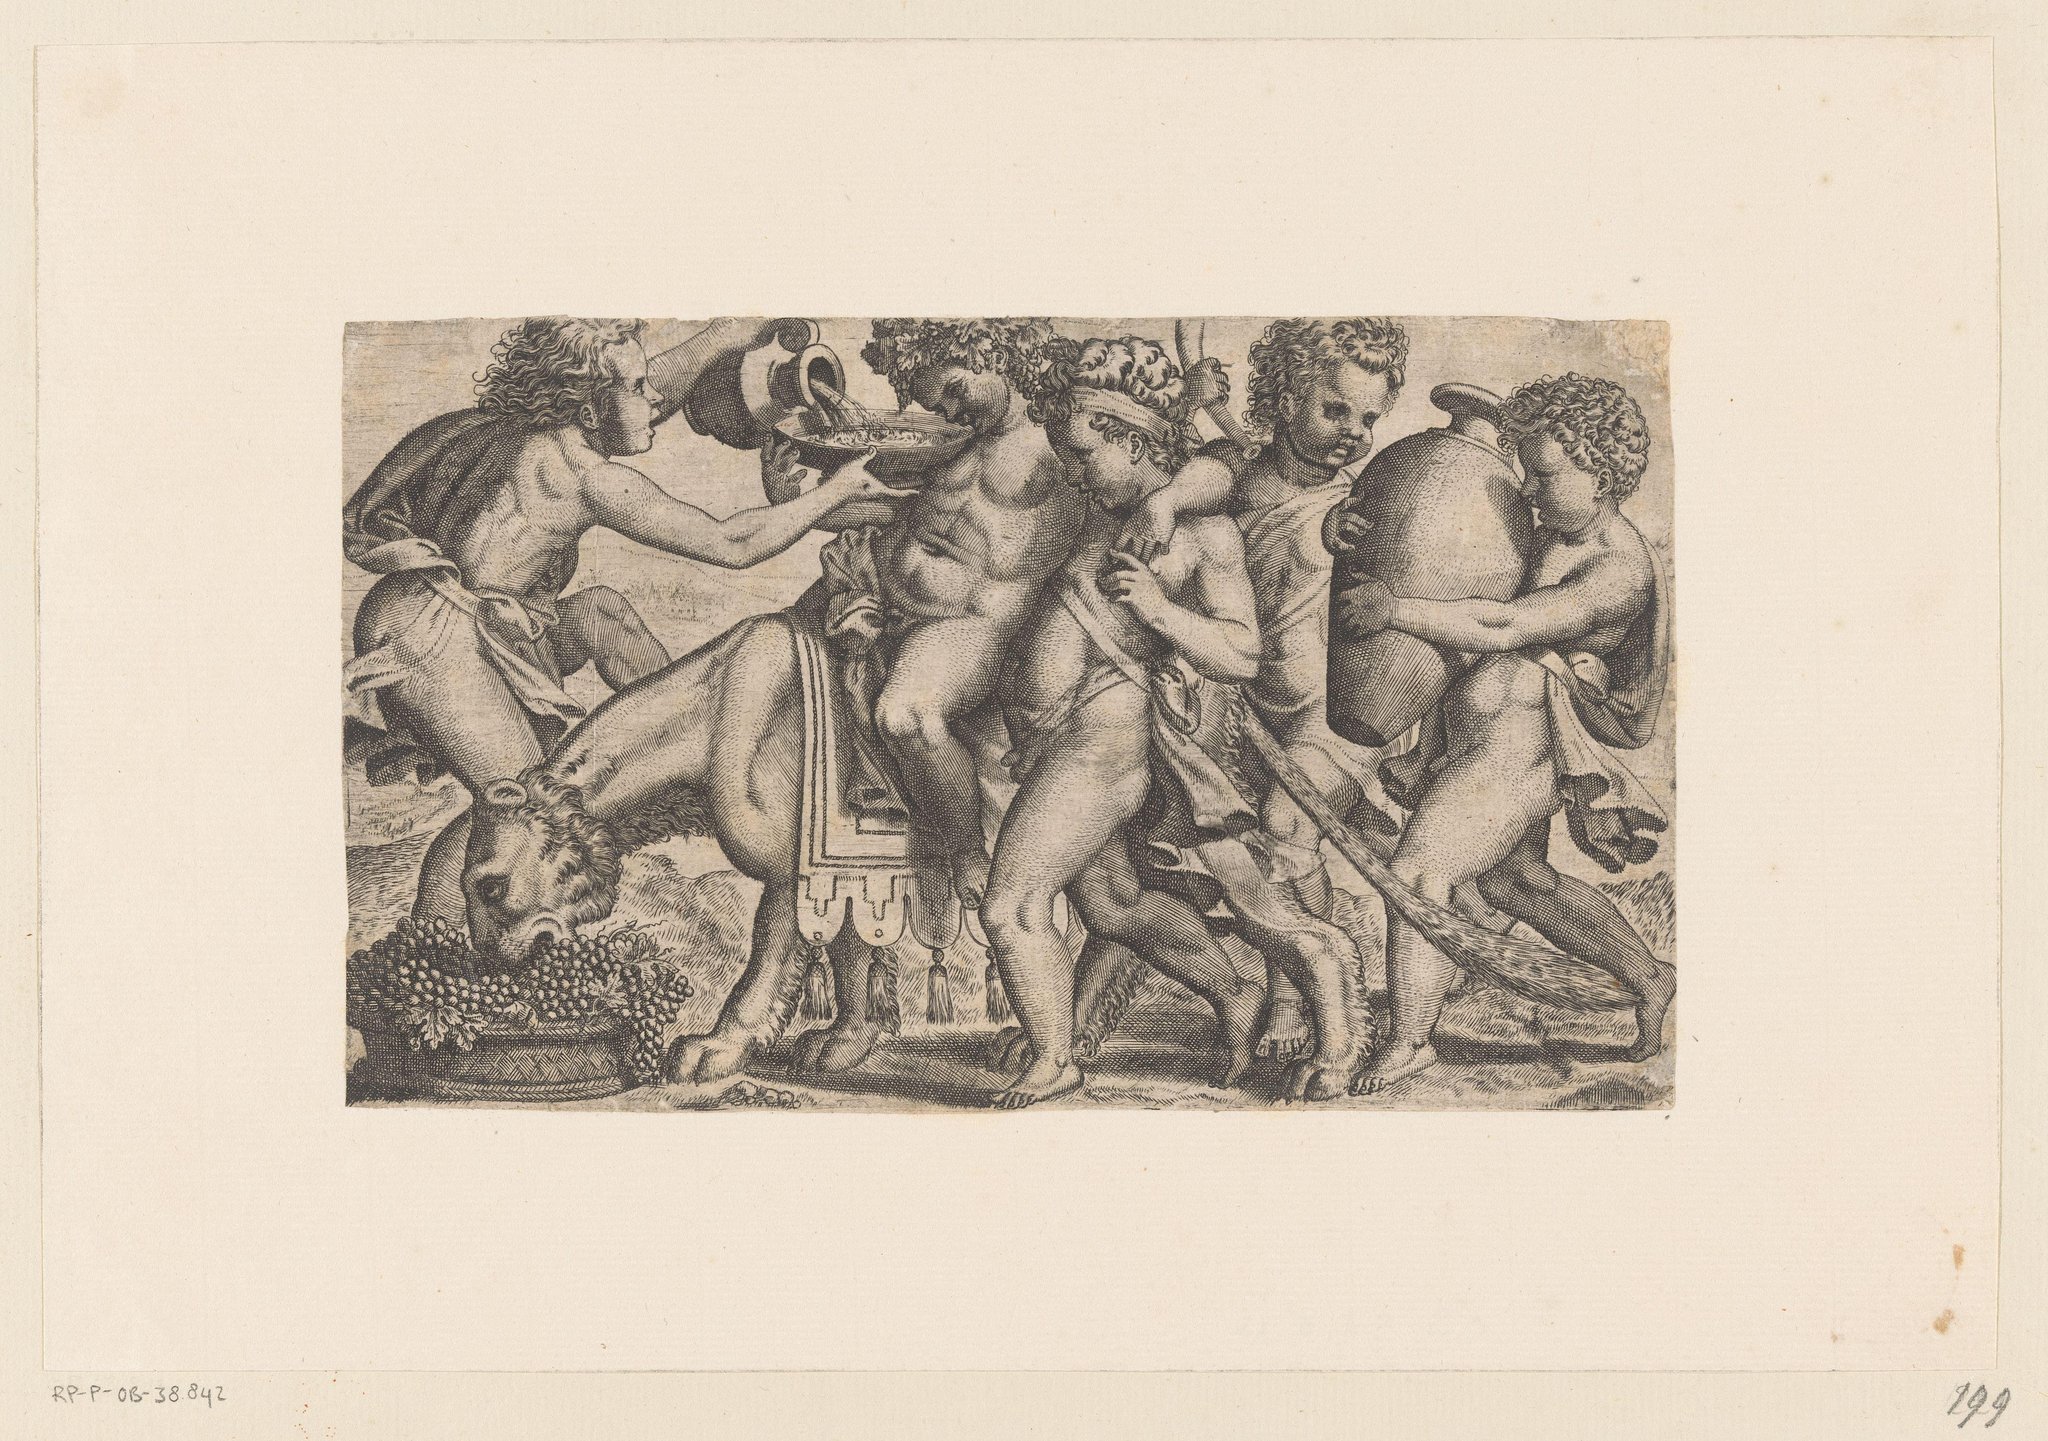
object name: print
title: Bacchanaal met vijf jongelingen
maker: Anonymous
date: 1500-1599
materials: paper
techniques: engraving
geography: italy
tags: children's bacchanal, beasts of prey, predatory animals: lion, bunch of grapes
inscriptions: collector's mark: Lugt 240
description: Een bacchanaal met vijf jongelingen waarvan één op de rug van een leeuw zit. De leeuw eet uit een mand met druiven. Links schenkt een jongeling een drinkschaal vol met wijn.